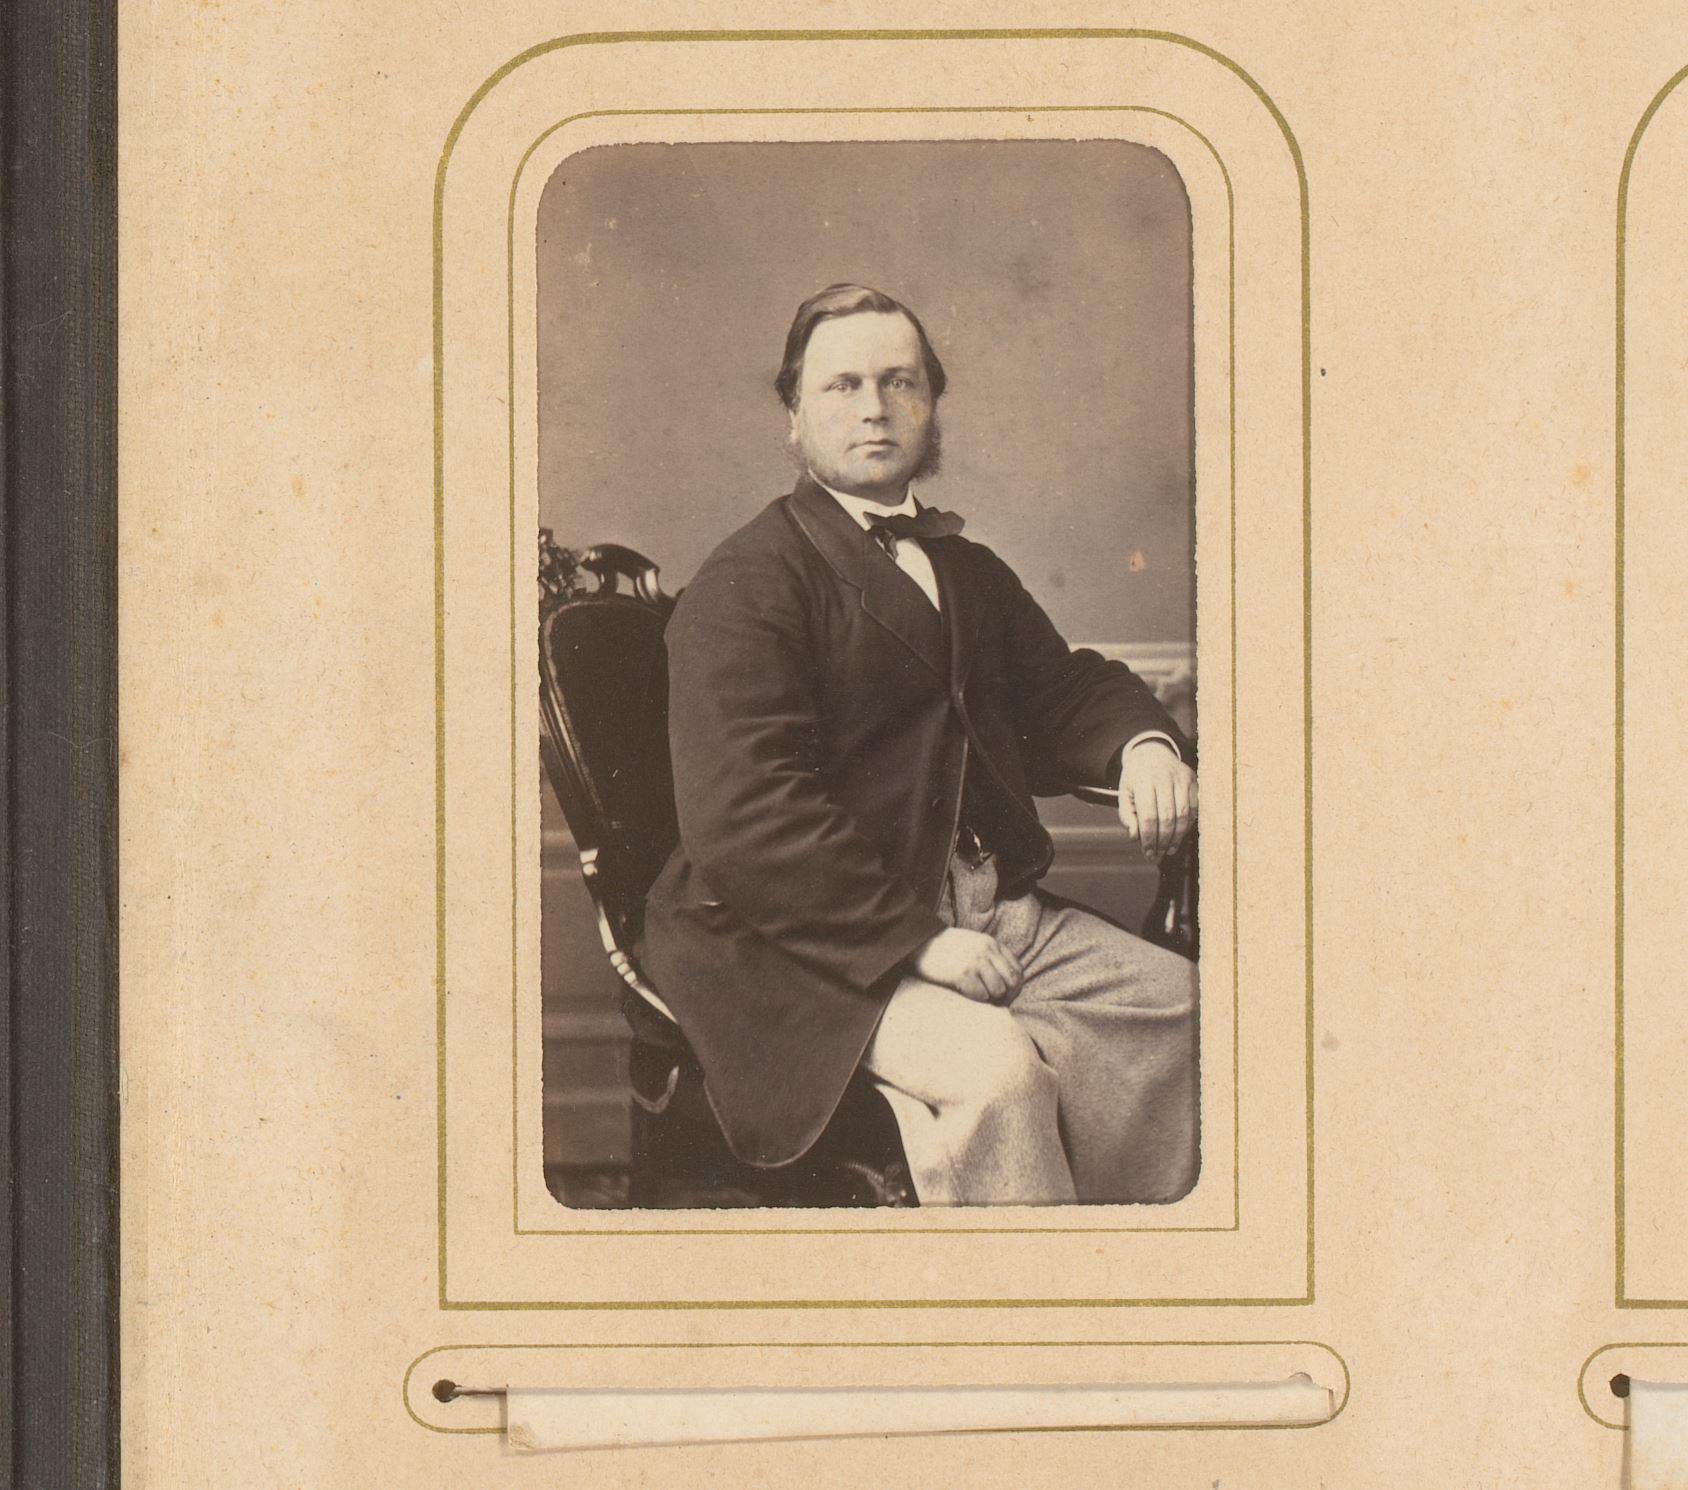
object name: album leaf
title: Portret van een zittende man met ringbaard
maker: a. böeseken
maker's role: fotograaf, lithograaf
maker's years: 1834-1919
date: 1858-1890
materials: cardboard, photographic support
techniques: albumen print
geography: rotterdam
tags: sitting figure, historical persons, beard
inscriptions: inscription: ‘Photographisch Atelier/ A. BÖESEKEN/ Hoogstraat over de Vlasmarkt/ ROTTERDAM.’